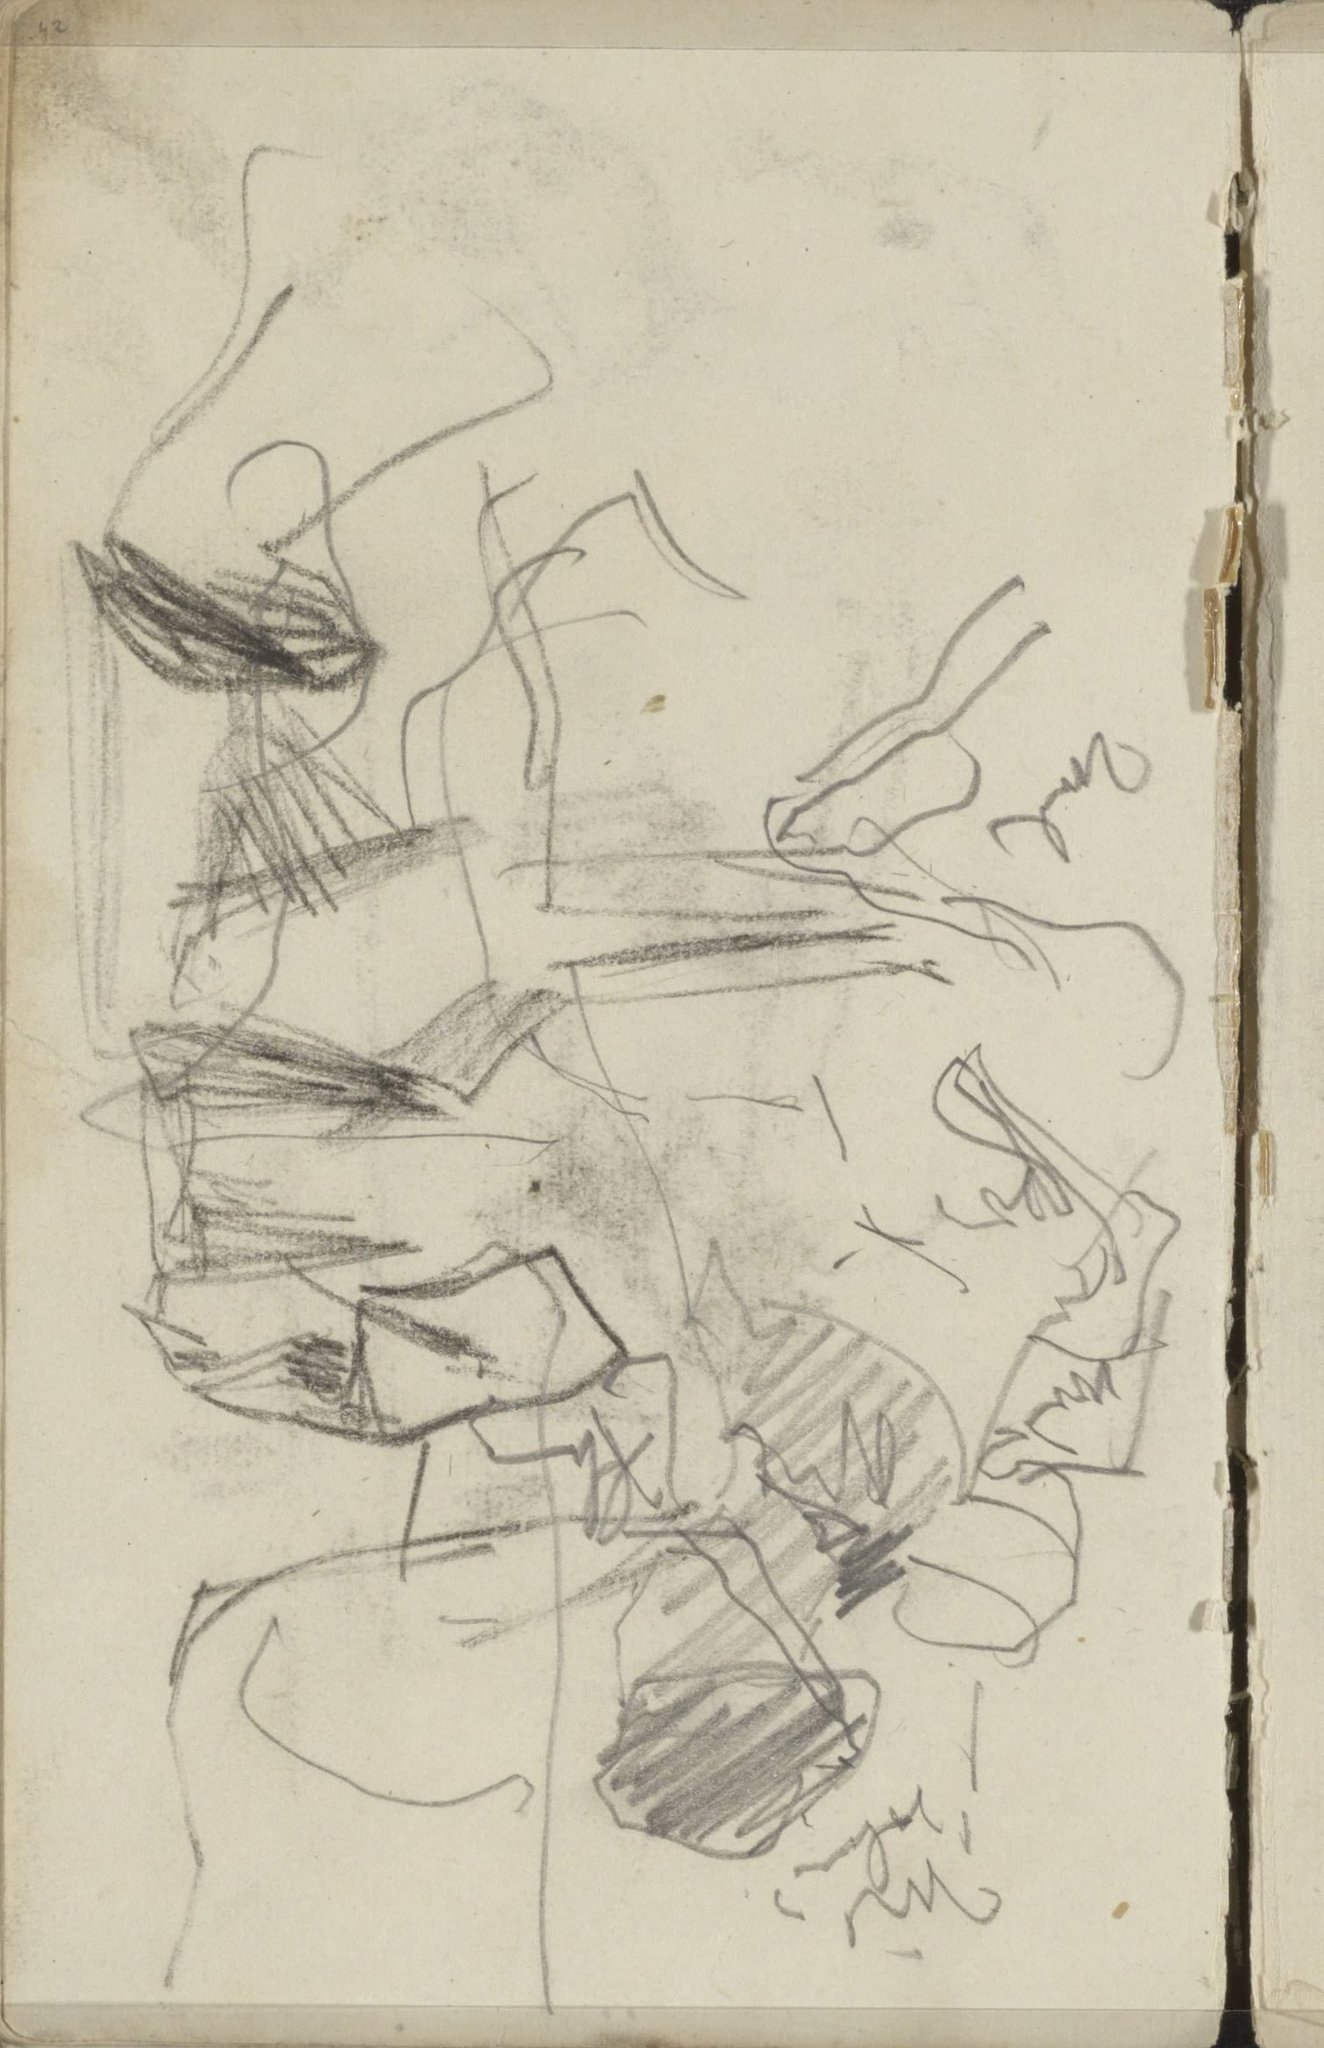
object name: sketchbook leaf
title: Paarden met haverzak en figuurstudies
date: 1881-1883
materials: chalk, paper, pencil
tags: adult woman, nose-bag (cattle), horse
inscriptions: kleurnotitie, handgeschreven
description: Pagina 42 uit een schetsboek met 29 bladen.